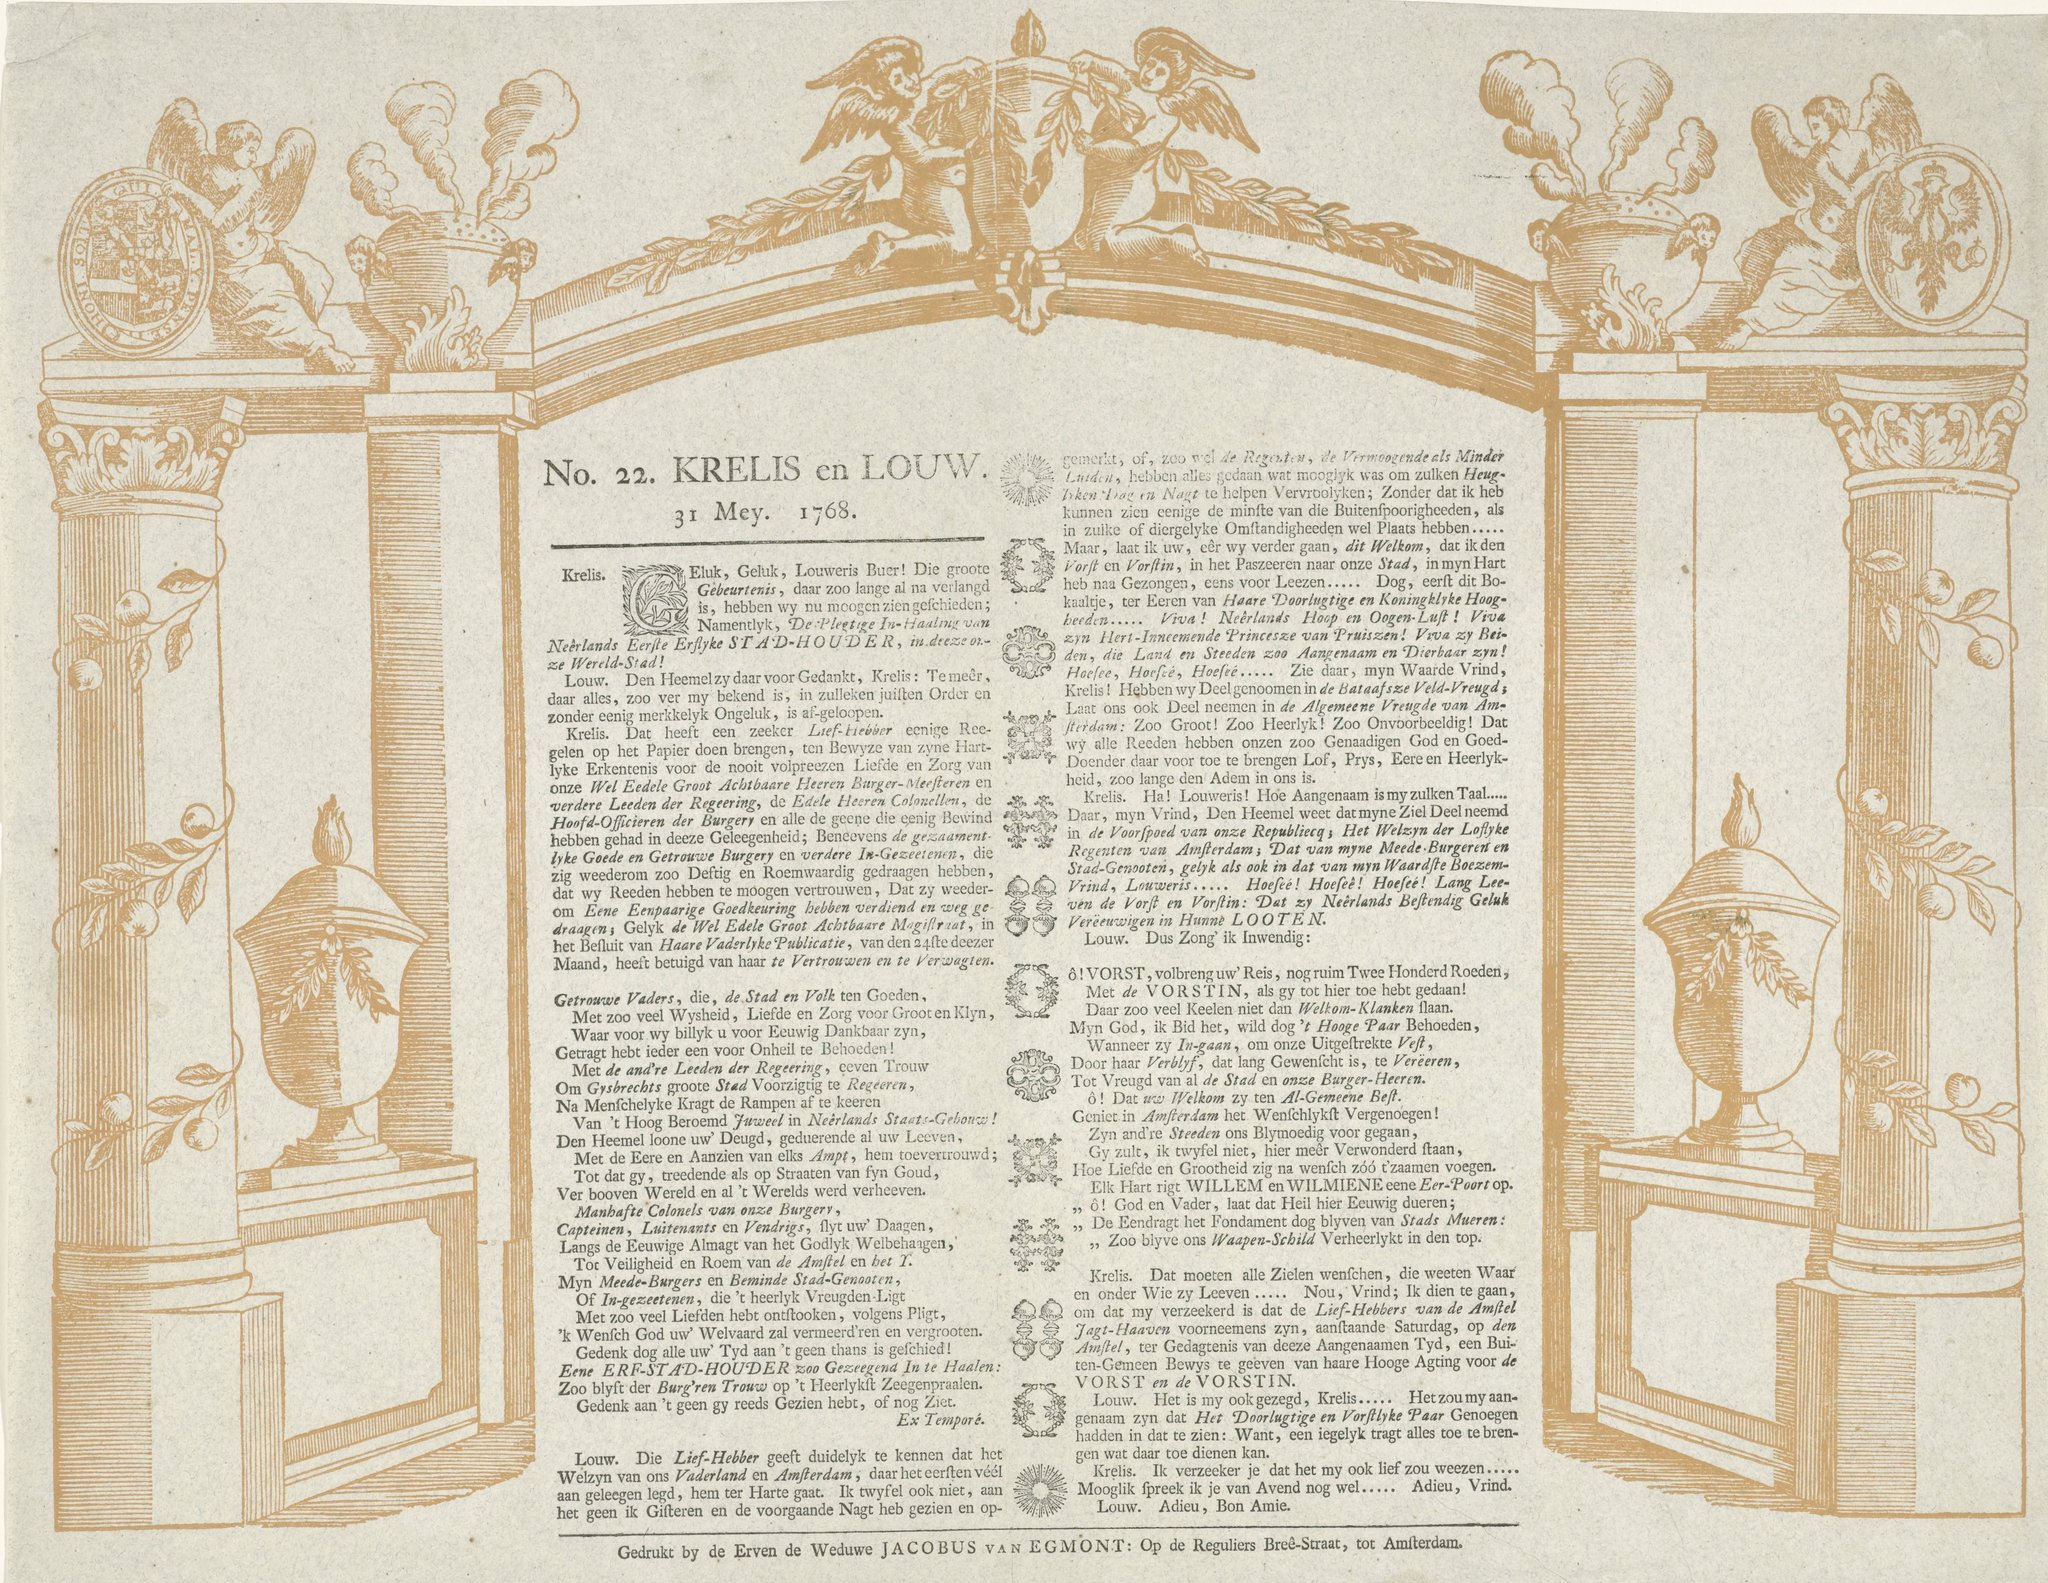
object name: print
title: No. 22. Krelis en Louw. 31 Mey. 1768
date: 1768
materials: paper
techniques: letterpress printing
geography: amsterdam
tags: the hague, william v (prince of orange), berlin, draughtsman, wilhelmina of prussia (princess of orange), triumphal entry and public reception, pageant, 'entrée solennelle', 'joyeuse entrée'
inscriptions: collector's mark: Lugt 2228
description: Samenspraak van Krelis en Louw ter gelegenheid van het bezoek van stadhouder Willem V en prinses Wilhelmina van Pruisen aan Amsterdam, 31 mei 1768. In het midden de tekst in twee kolommen, met ornamentele rand in de vorm van een triomfboog met zuilen, urnen, wierookvaten en engelen met de wapens van het prinselijk paar.